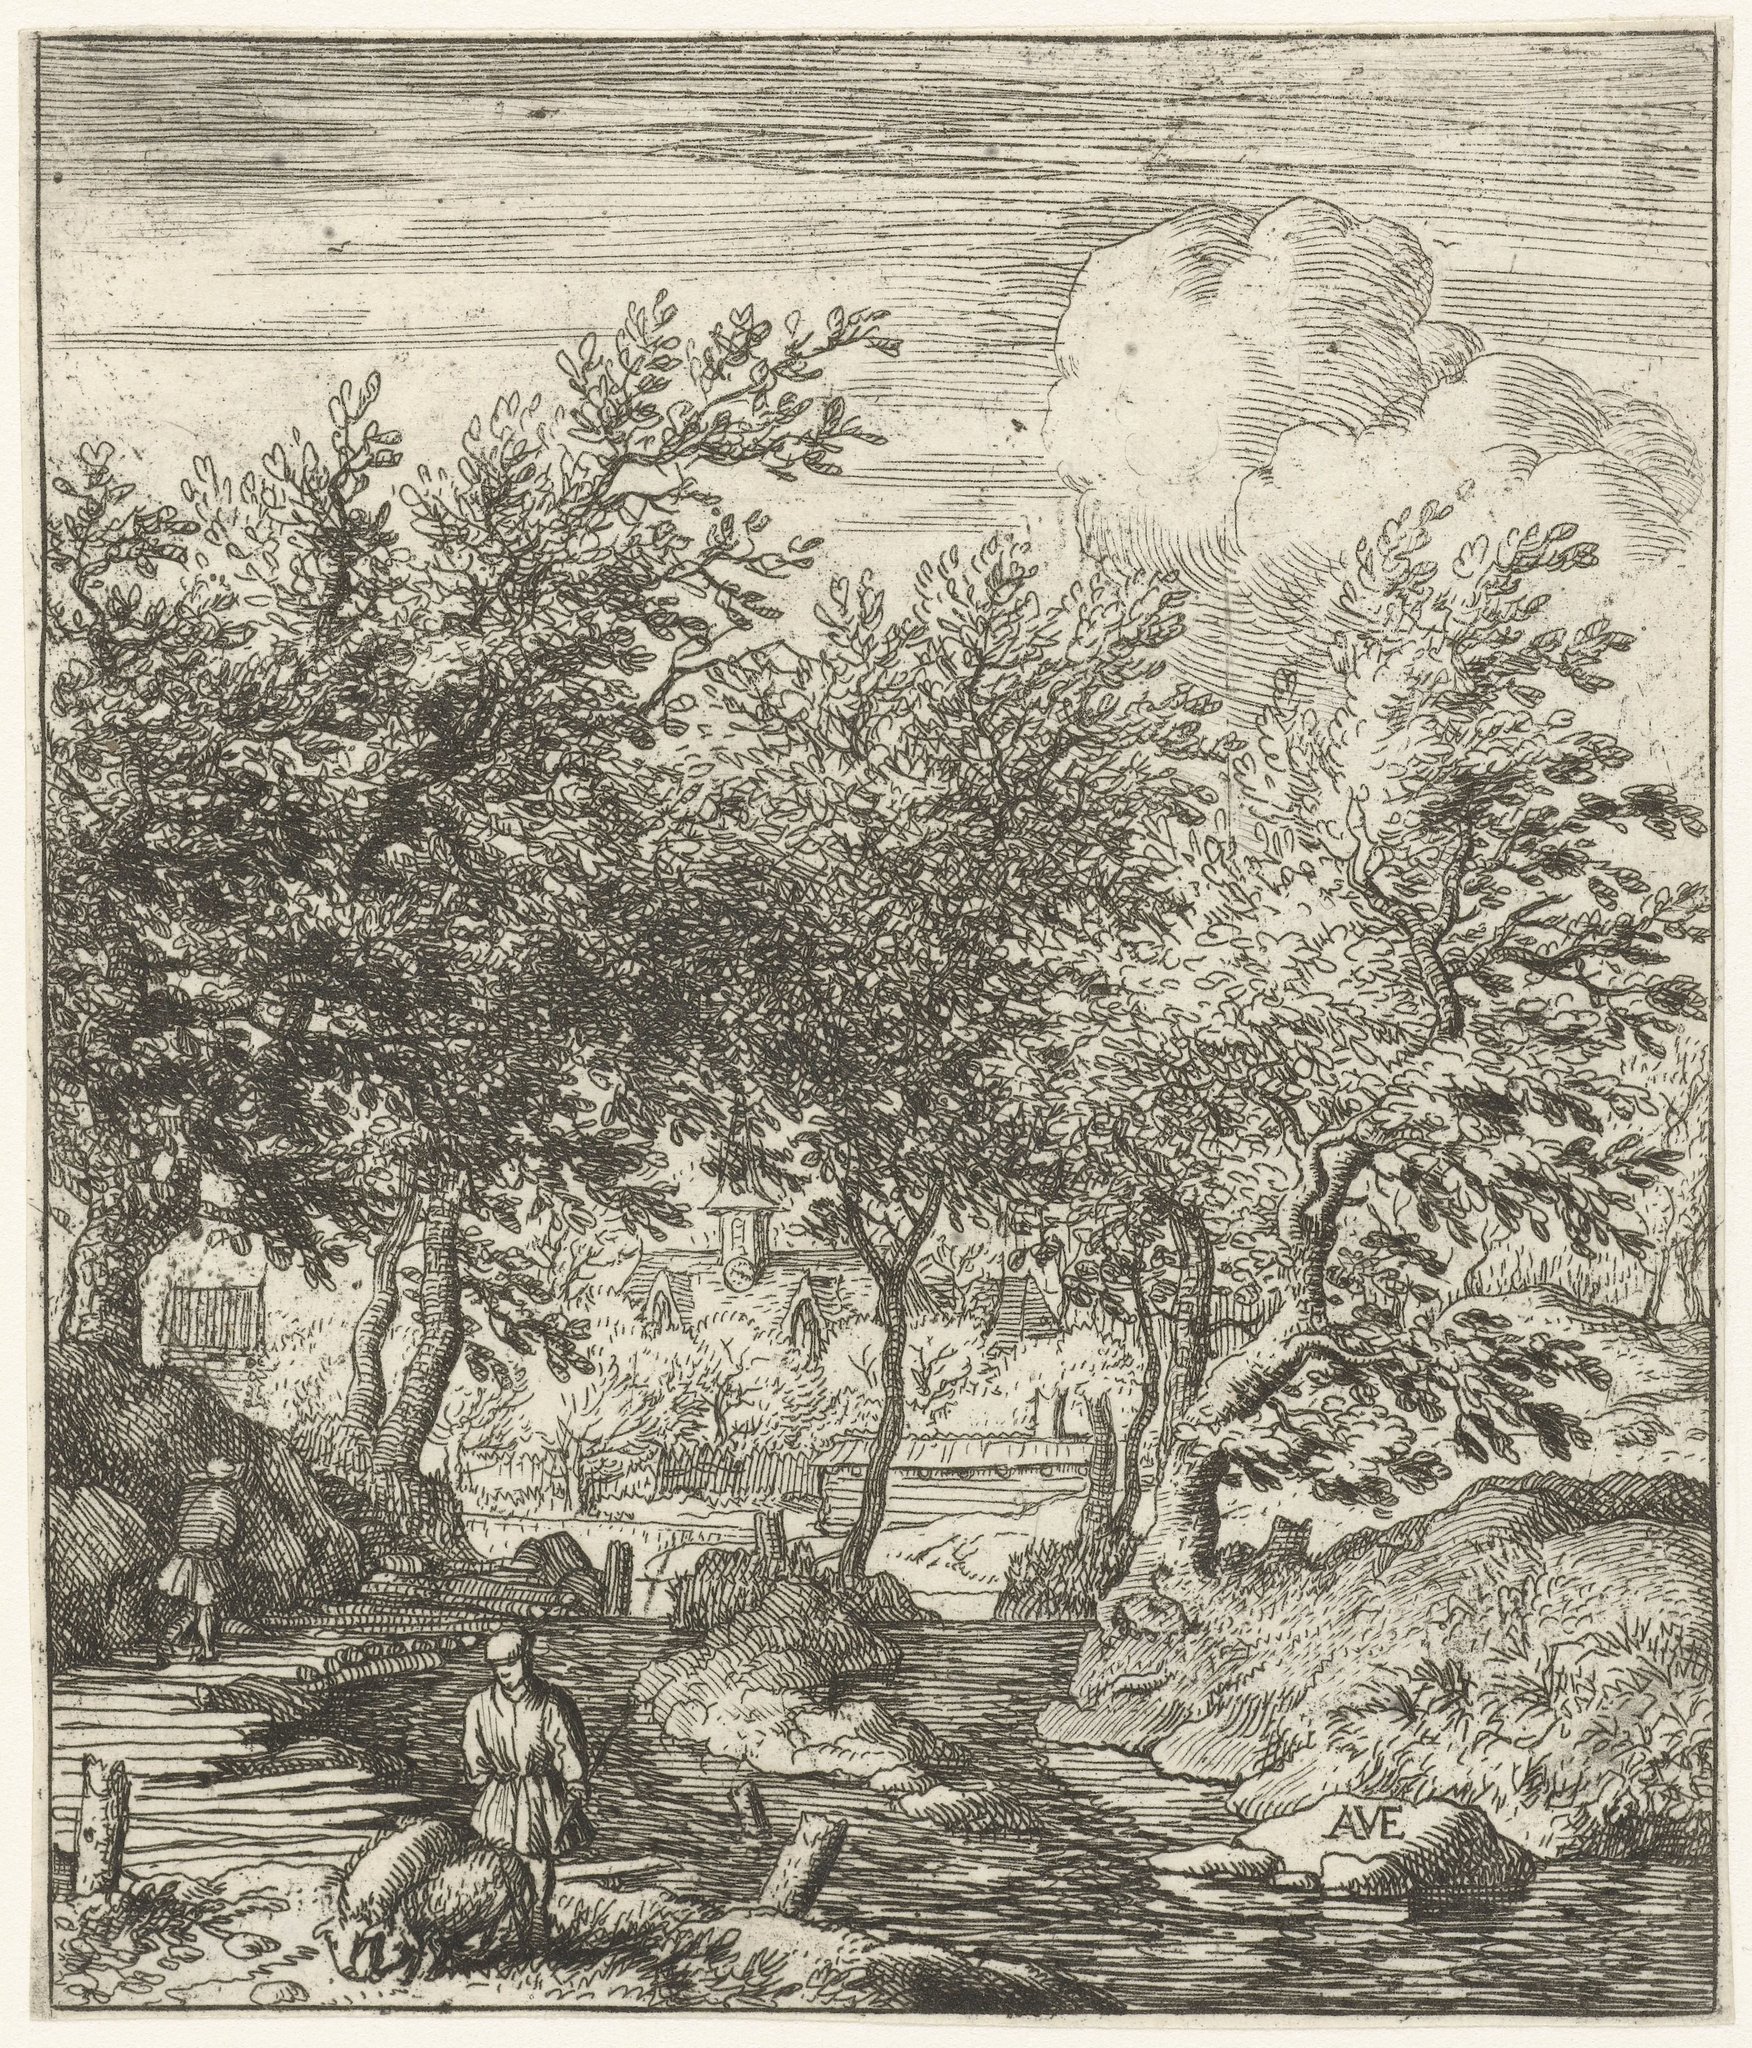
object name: print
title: Landschap met varkenshoeder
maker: allaert van everdingen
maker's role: draughtsman, painter, print maker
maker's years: 1621-1675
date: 1631-1675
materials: paper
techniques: etching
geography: netherlands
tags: landscapes (+ landscape with figures, staffage)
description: Landschap met hoge bomen en een kerk op de achtergrond. Op het pad langs de rivier staat een man met twee varkens.